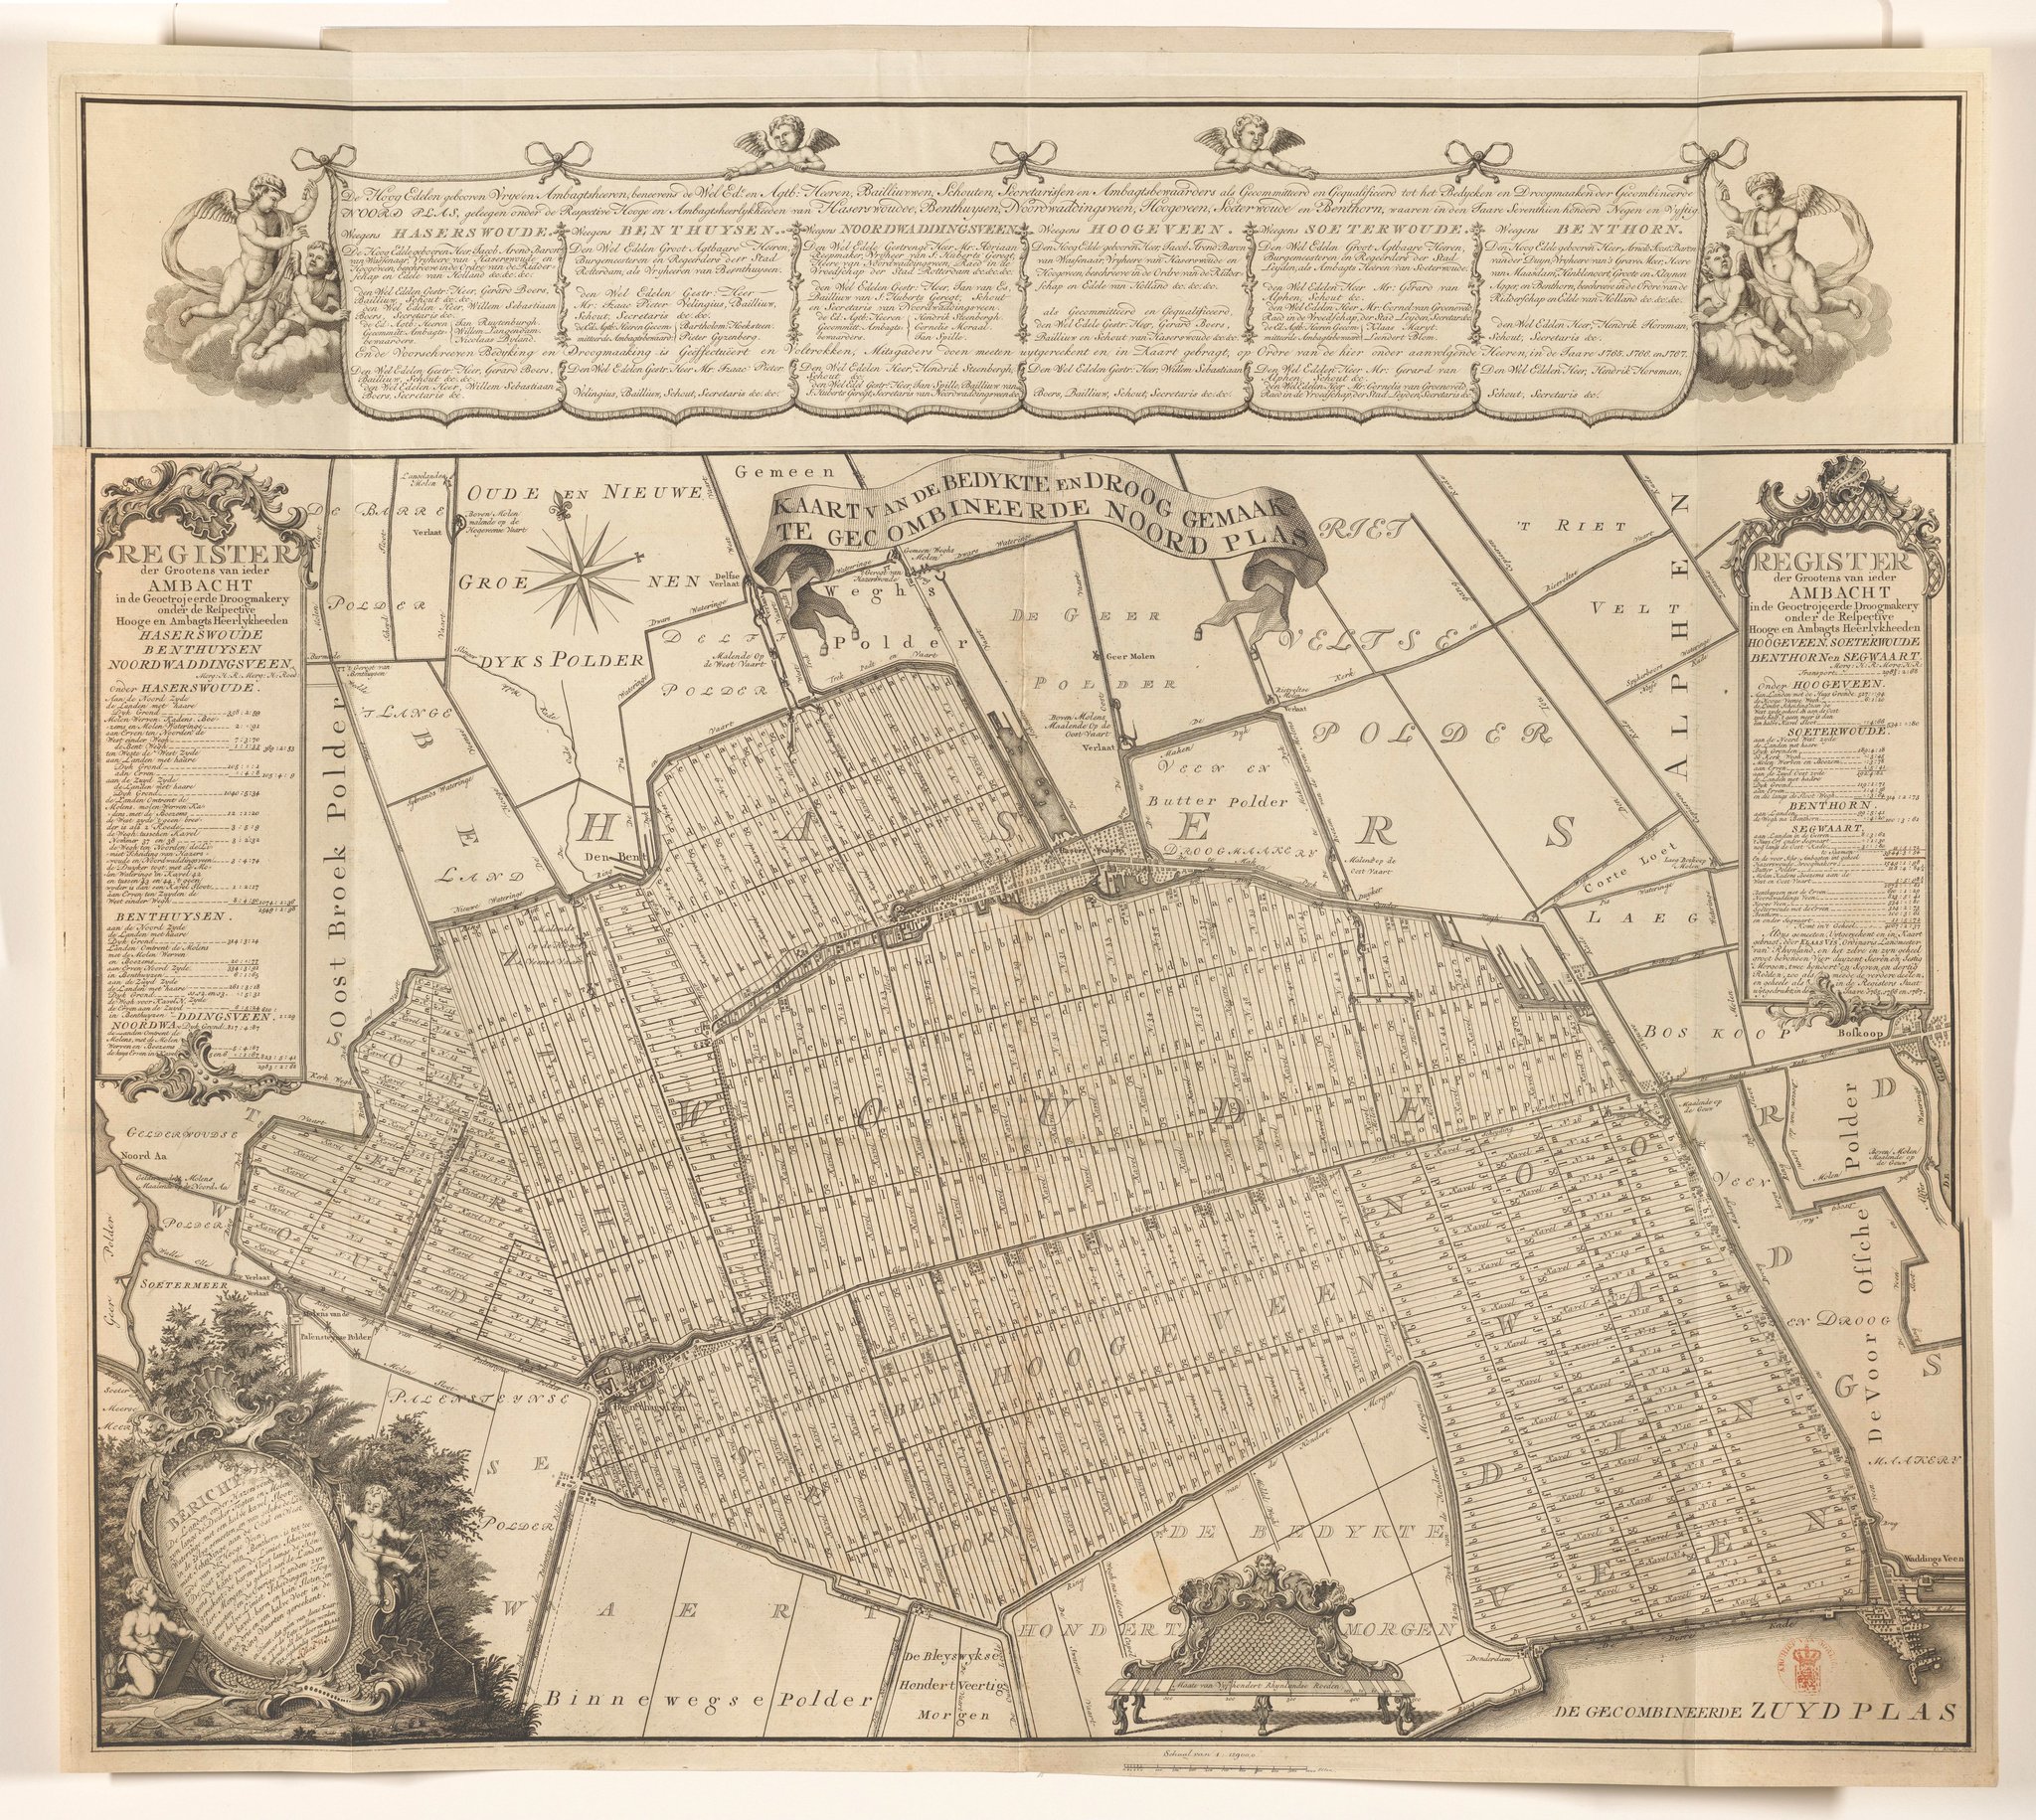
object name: print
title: Kaart van de Noordplaspolder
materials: ink, paper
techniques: engraving, etching, pen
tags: maps of separate countries or regions, polder, reclaimed land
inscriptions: inscription: ‘Schaal van 1:12900,0’, collector's mark: Lugt 2228, inscription: ‘Klaas Vis’, collector's mark: Lugt 19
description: Langs de bovenkant de namen van de ambachtsheren van Hazerswoude, Benthuizen, Noord-Waddinxveen, Hogeveen, Zoeterwoude en Benthorn. Daaronder in het midden een banderol met de titel. Links en rechts een cartouche met een register met de grootte van verschillende oppervlaktes van de ambachten binnen de droogmakerij. Linksonder een cartouche met tekst, met de hand ondertekend door Klaas Vis. Onder rechts van het midden een schaalstok: Maate van vyfhondert Rhynlandse roeden.